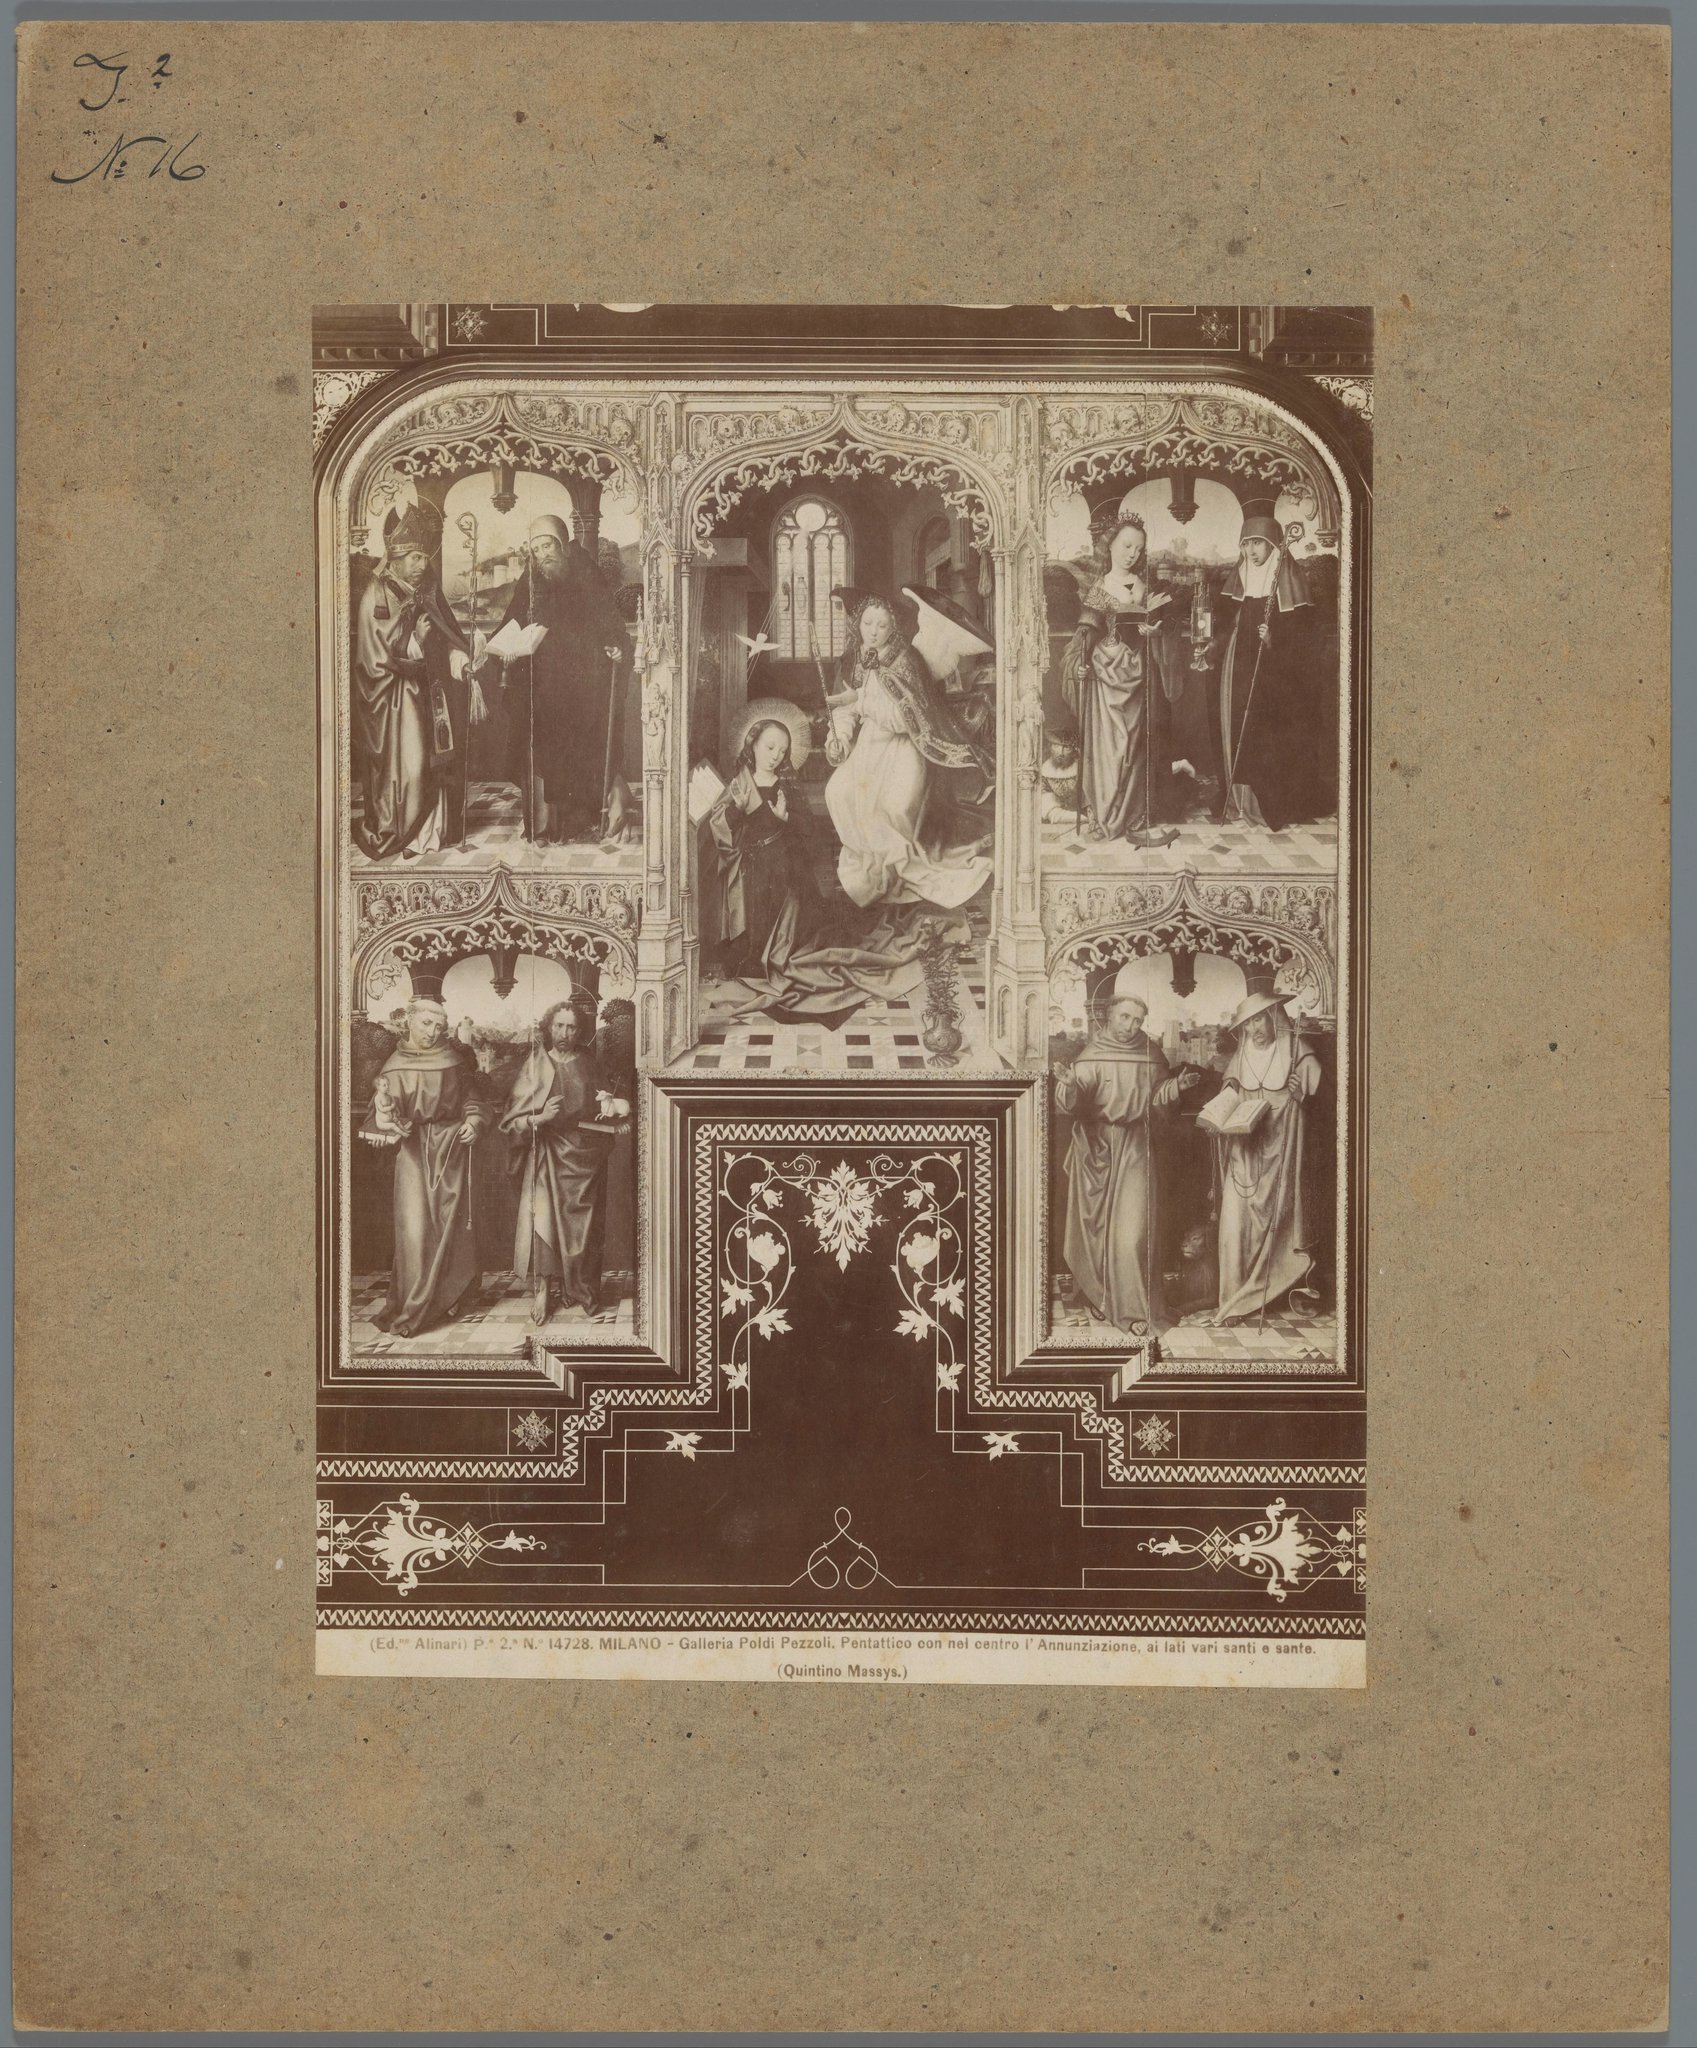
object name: photograph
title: MILANO - Galleria Poldi Pezzoli. Pentattico con nel centro l'Annunziazione, ai lati vari santi e sante.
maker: quinten massijs (i)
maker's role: draughtsman, painter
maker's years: 1466-1530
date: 1875-1900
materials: cardboard, photographic support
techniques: albumen print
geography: museo poldi pezzoli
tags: the annunciation: mary kneeling, saints, female saints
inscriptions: number: ‘P.e 2.a N.o 14728.’, collector's mark: Lugt 3937